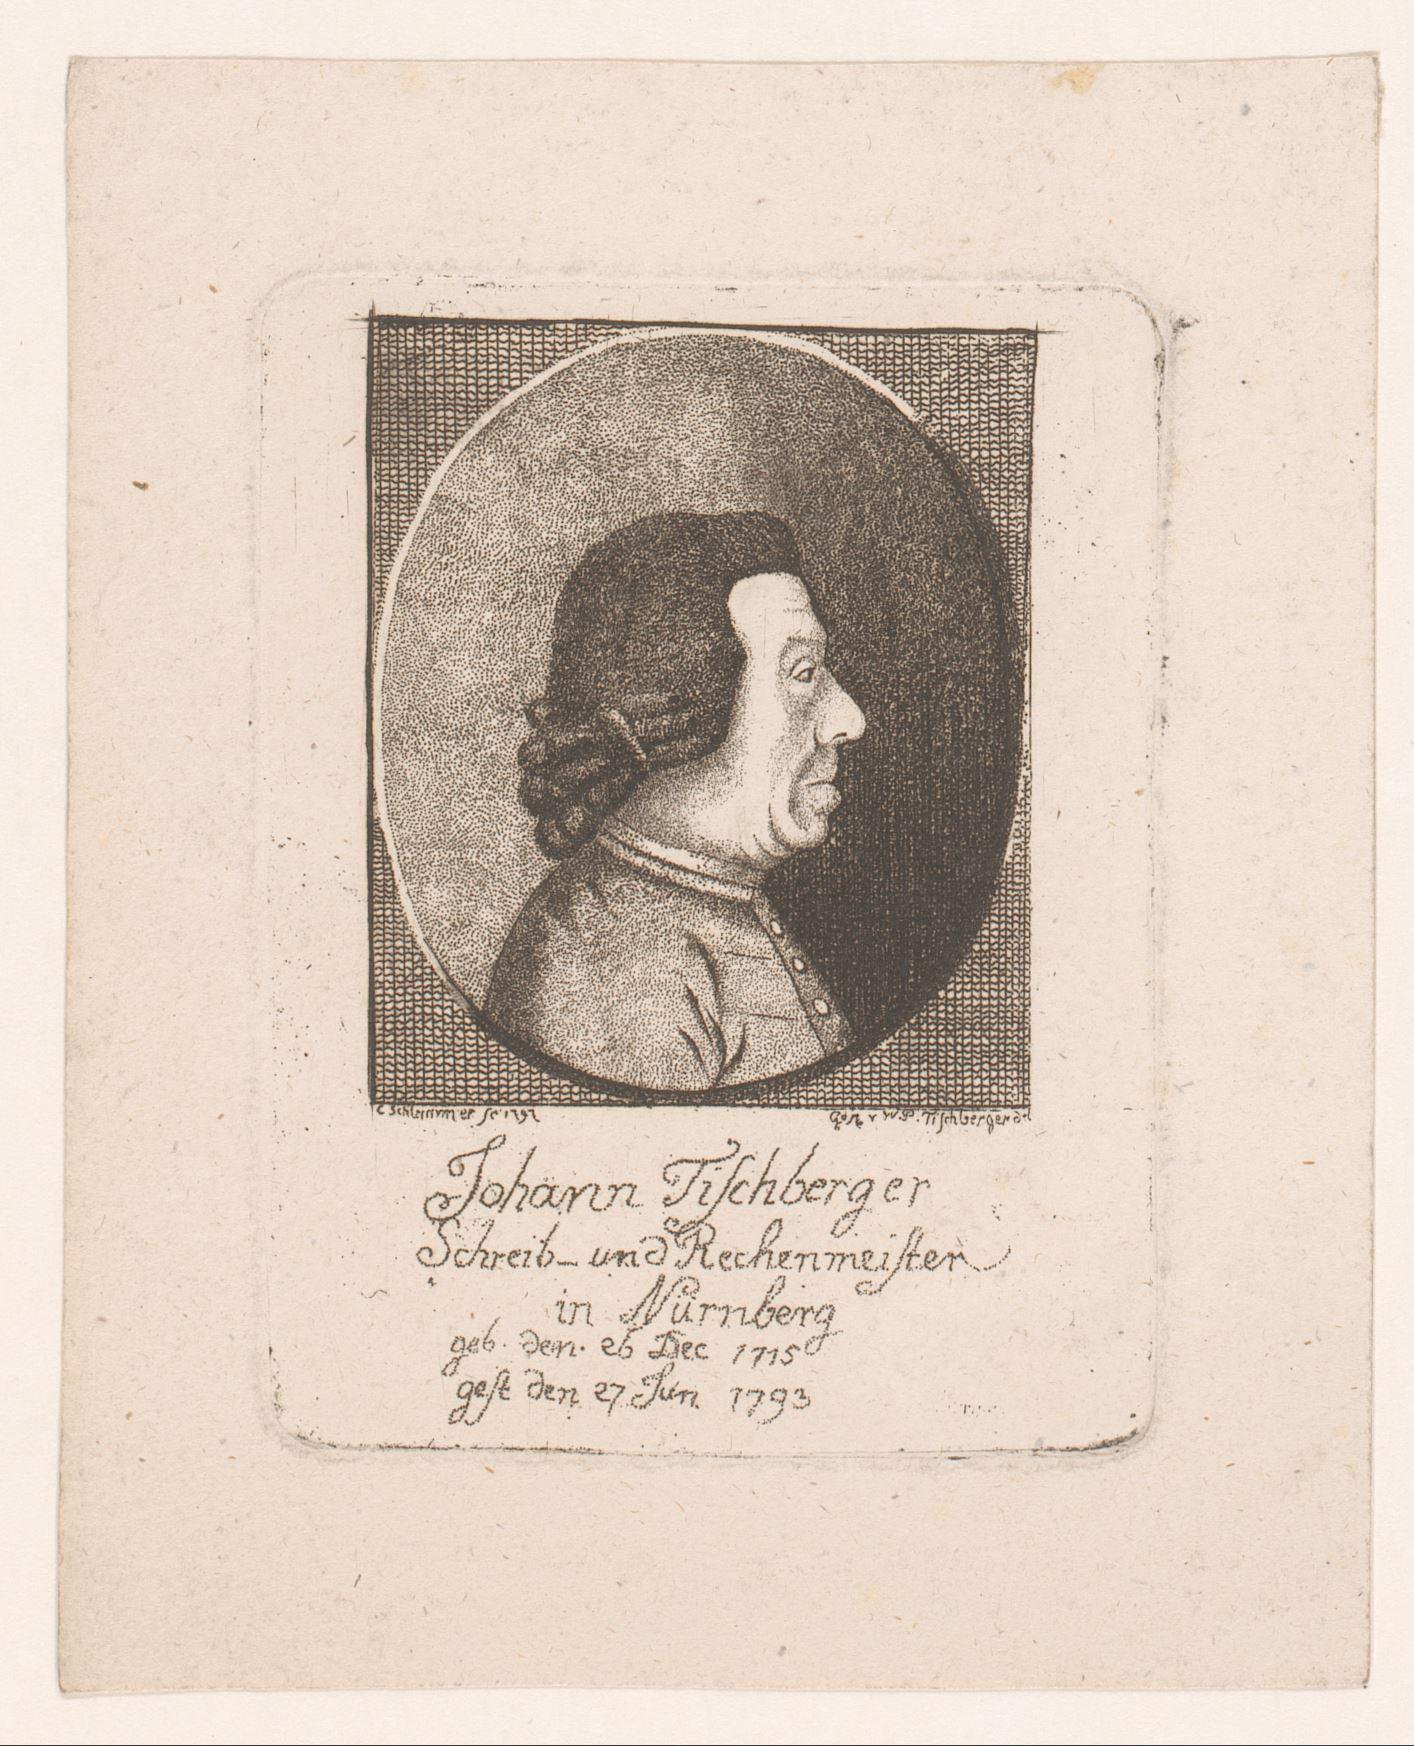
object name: print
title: Portret van Johann Tischberger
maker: leonhard schlemmer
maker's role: print maker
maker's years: 1772-1848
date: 1793-1818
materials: paper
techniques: etching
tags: historical persons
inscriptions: collector's mark: Lugt 2228